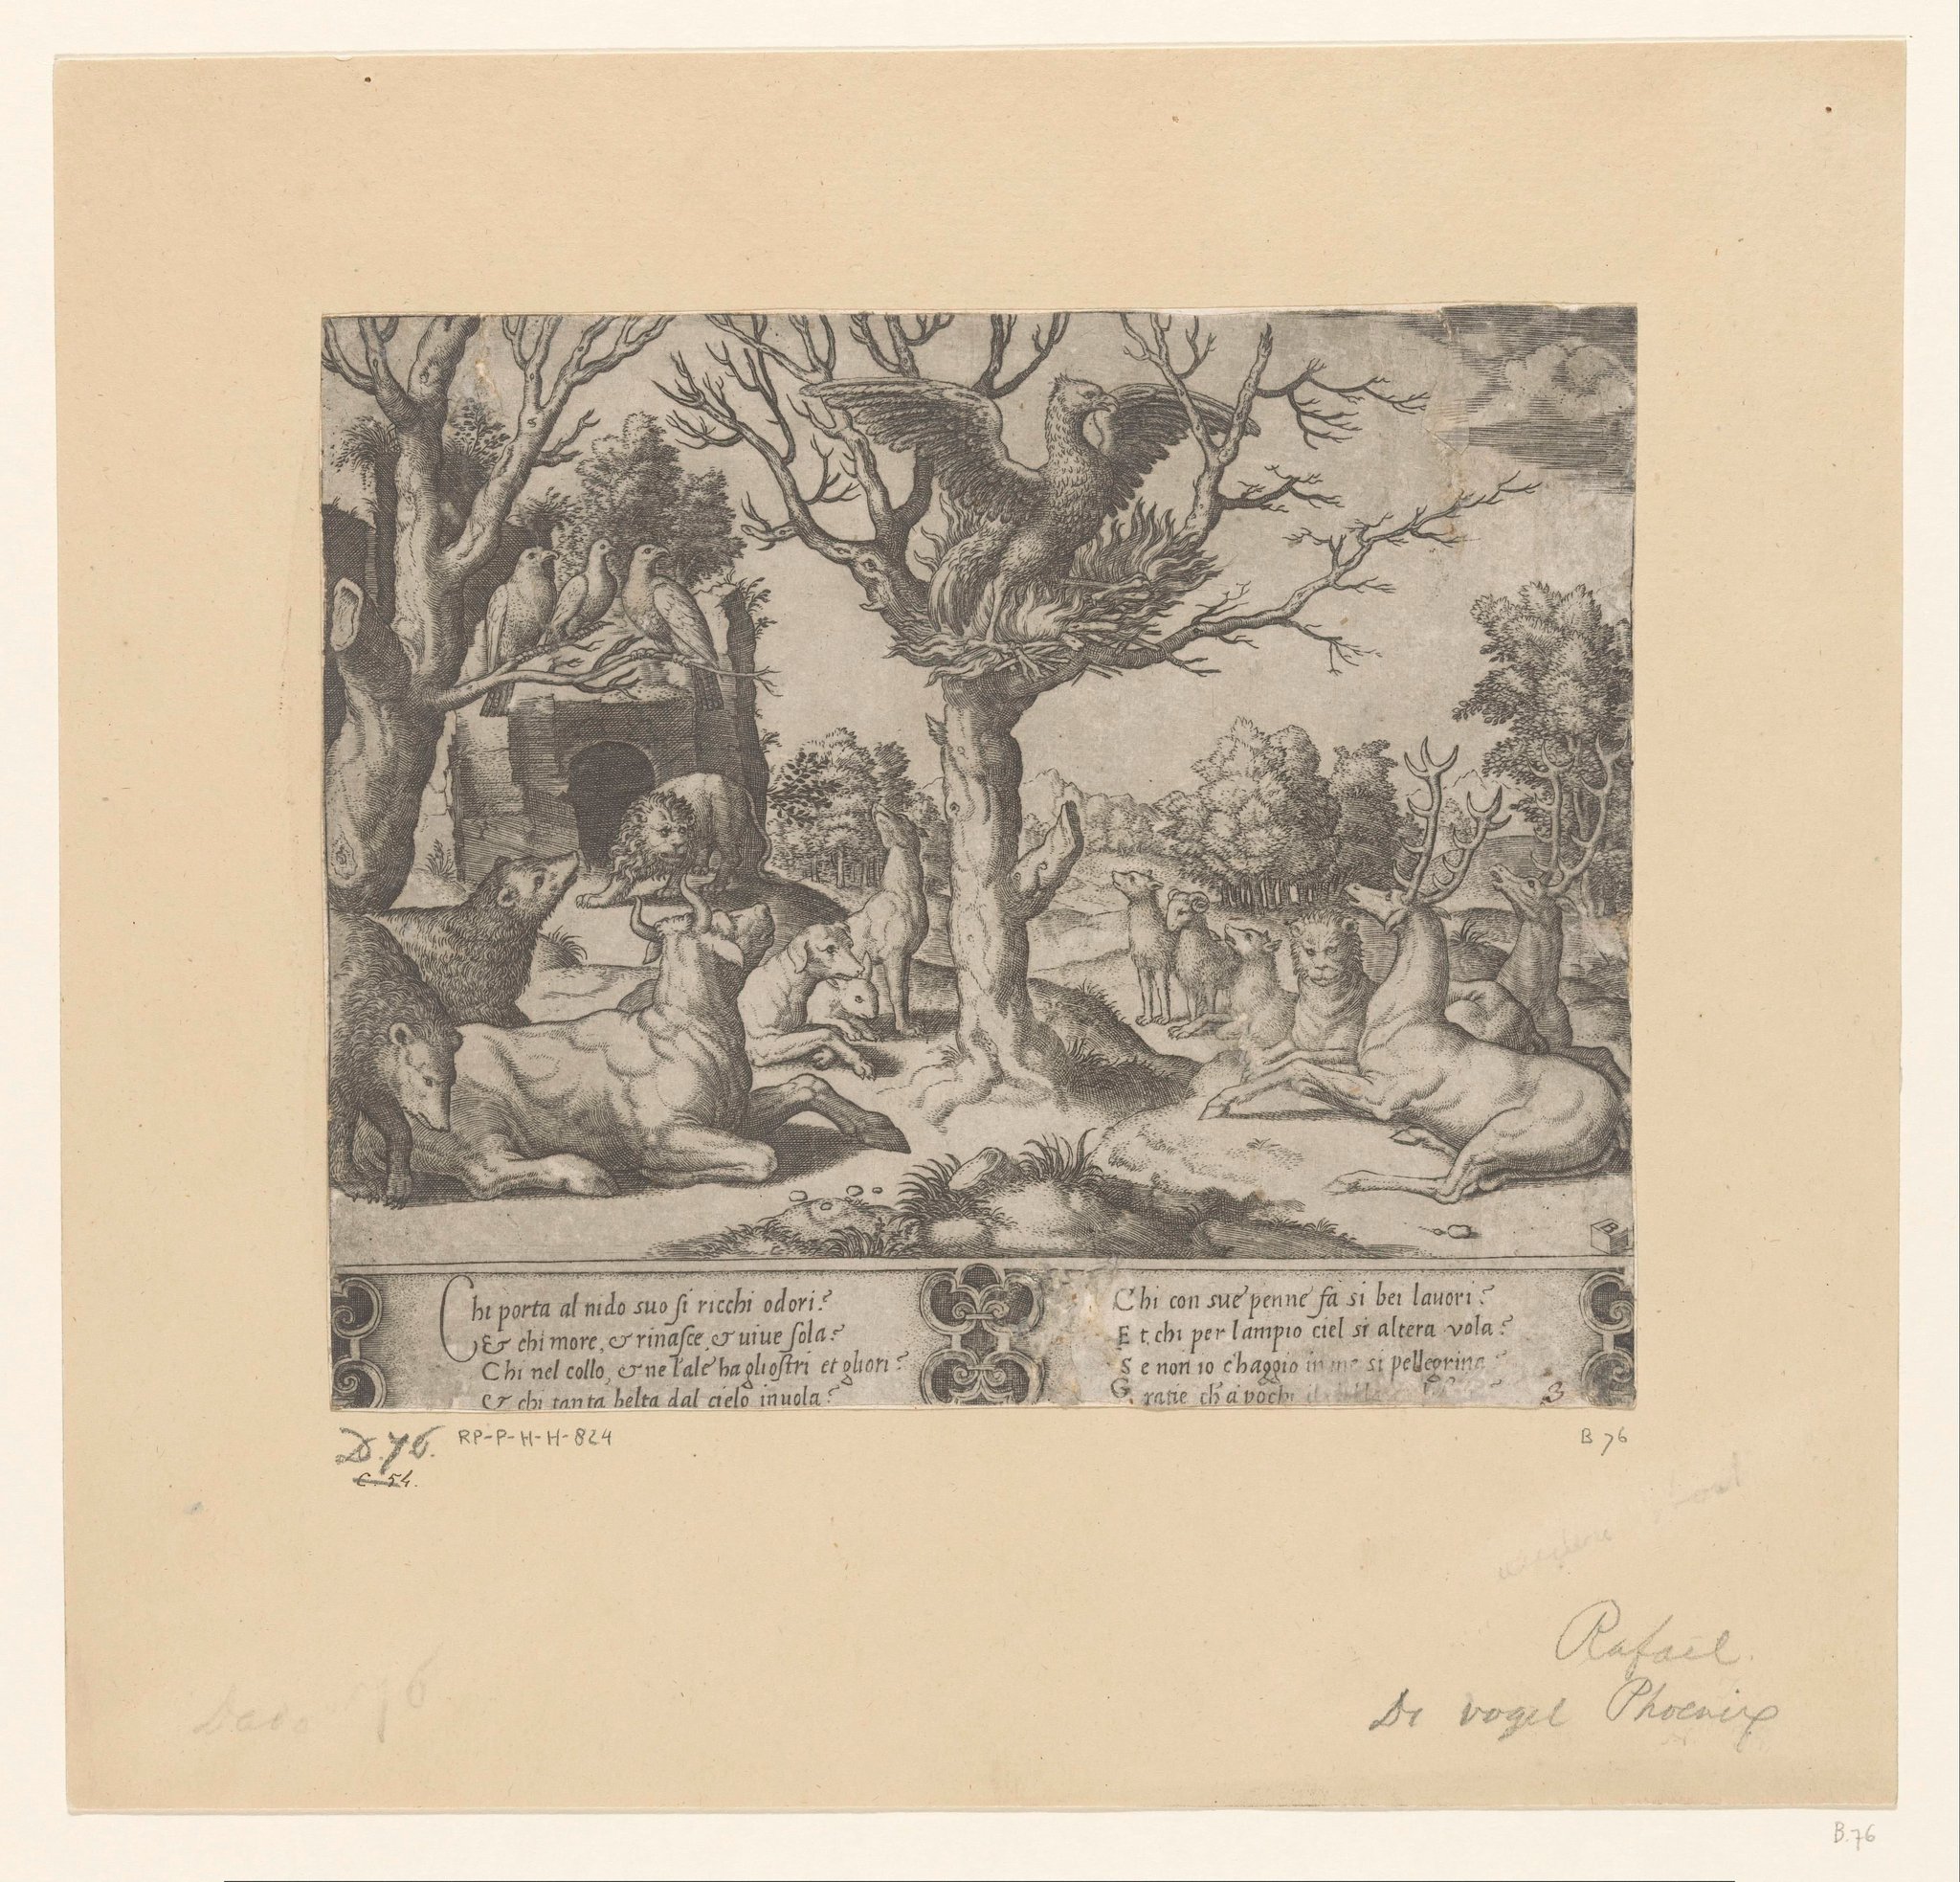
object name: print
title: Feniks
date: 1530-1560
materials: paper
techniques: engraving, intaglio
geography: italy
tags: fabulous animals ~ birds: phoenix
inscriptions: collector's mark: Lugt 11, collector's mark: ‘Hinloopen’, collector's mark: Lugt 10, number: ‘3’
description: Een zichzelf verbrandende feniks in een boom, omringd door andere dieren waaronder beren, honden en herten. Italiaanse tekst in twee kolommen in ondermarge.